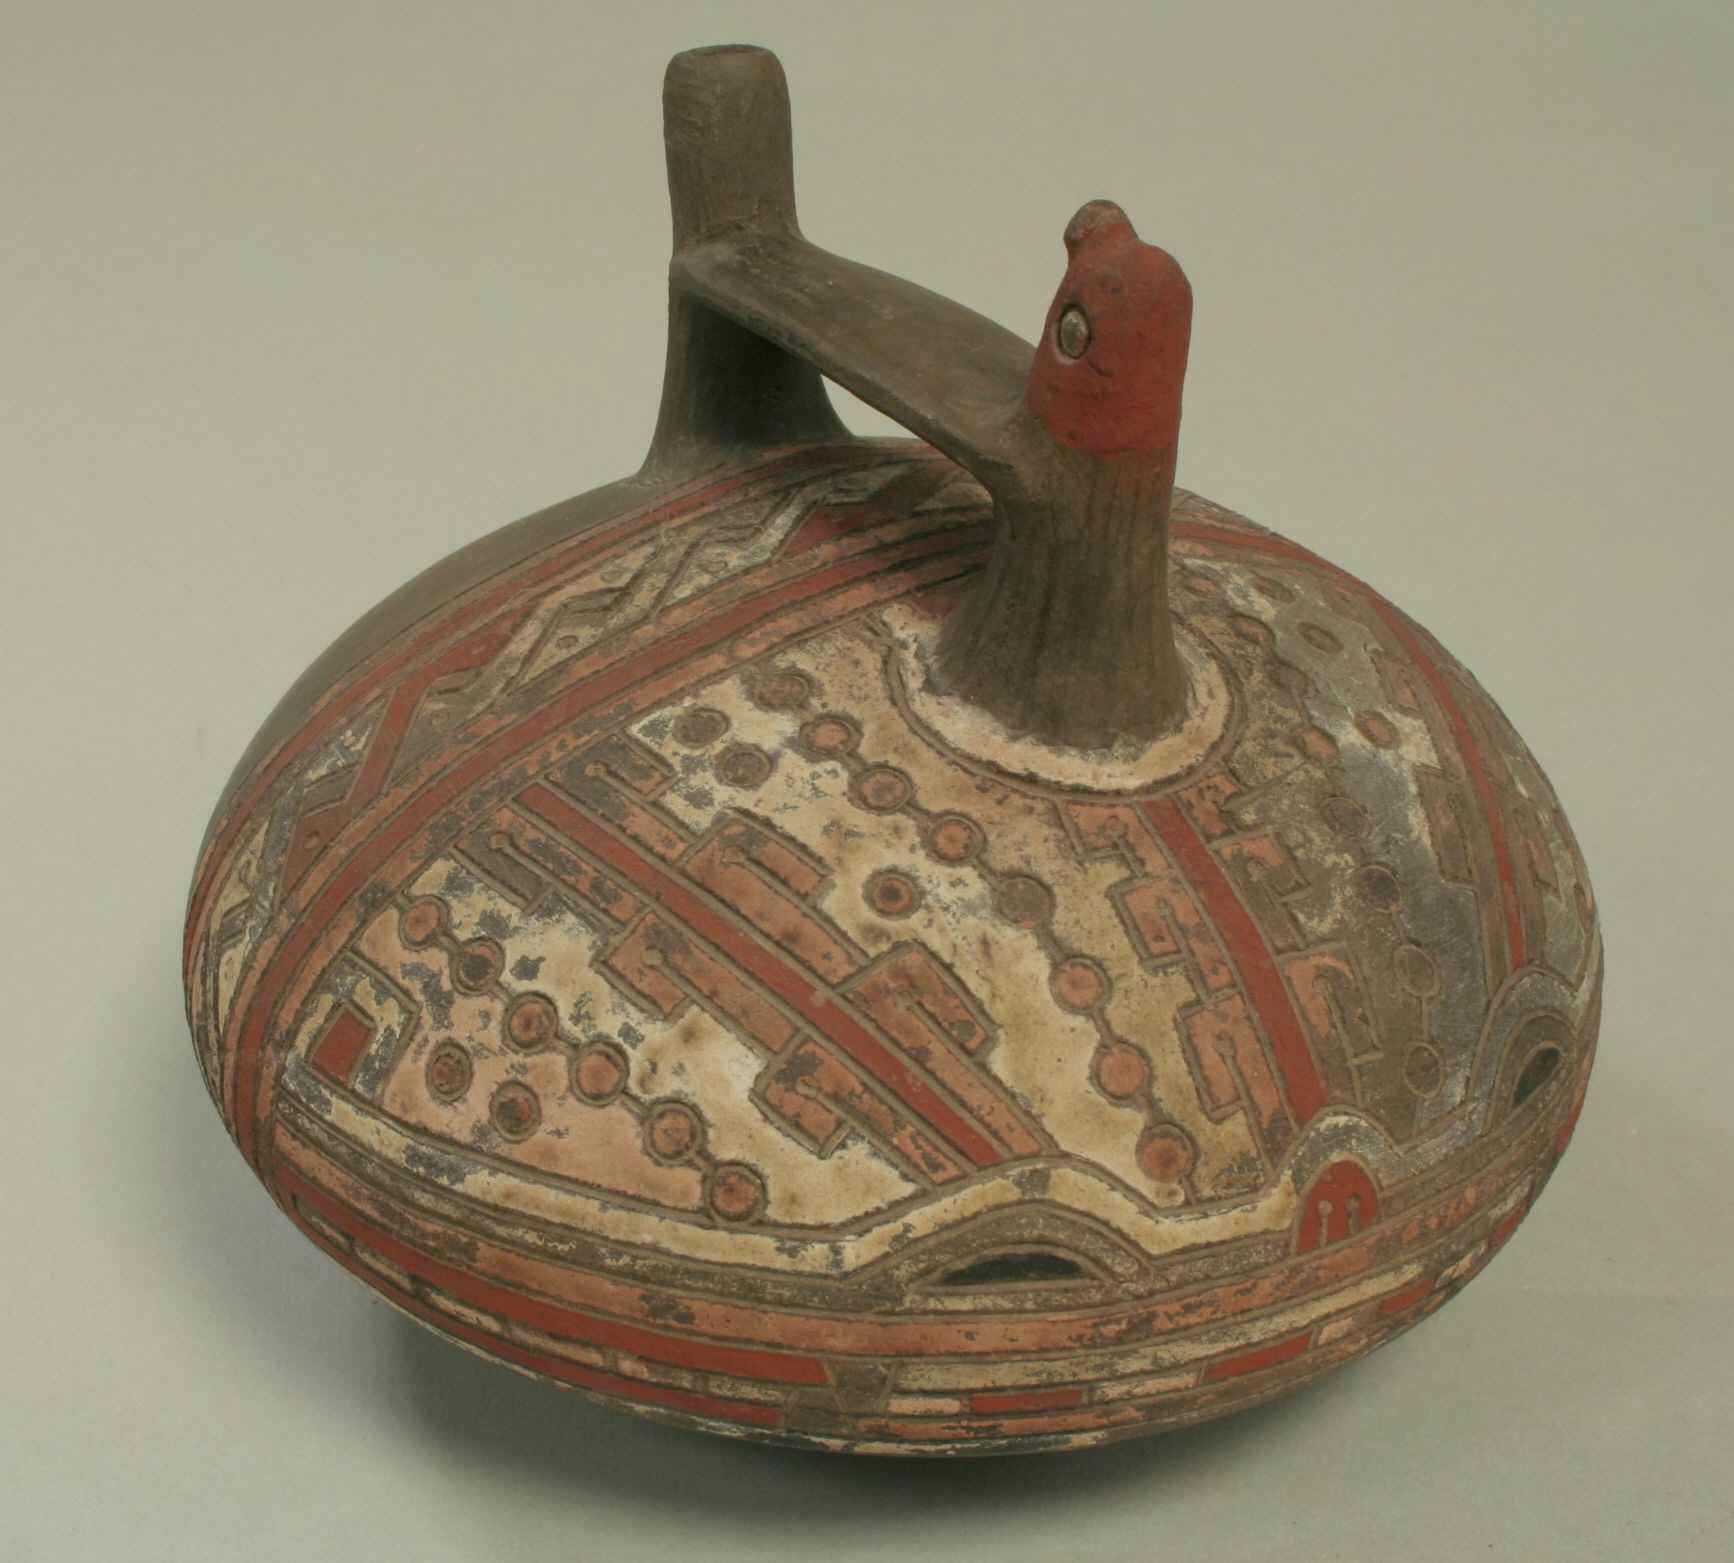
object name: bottle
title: Double Spout and Bridge Bottle with Bird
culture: paracas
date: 500-101 BCE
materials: ceramic, pigment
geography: peru